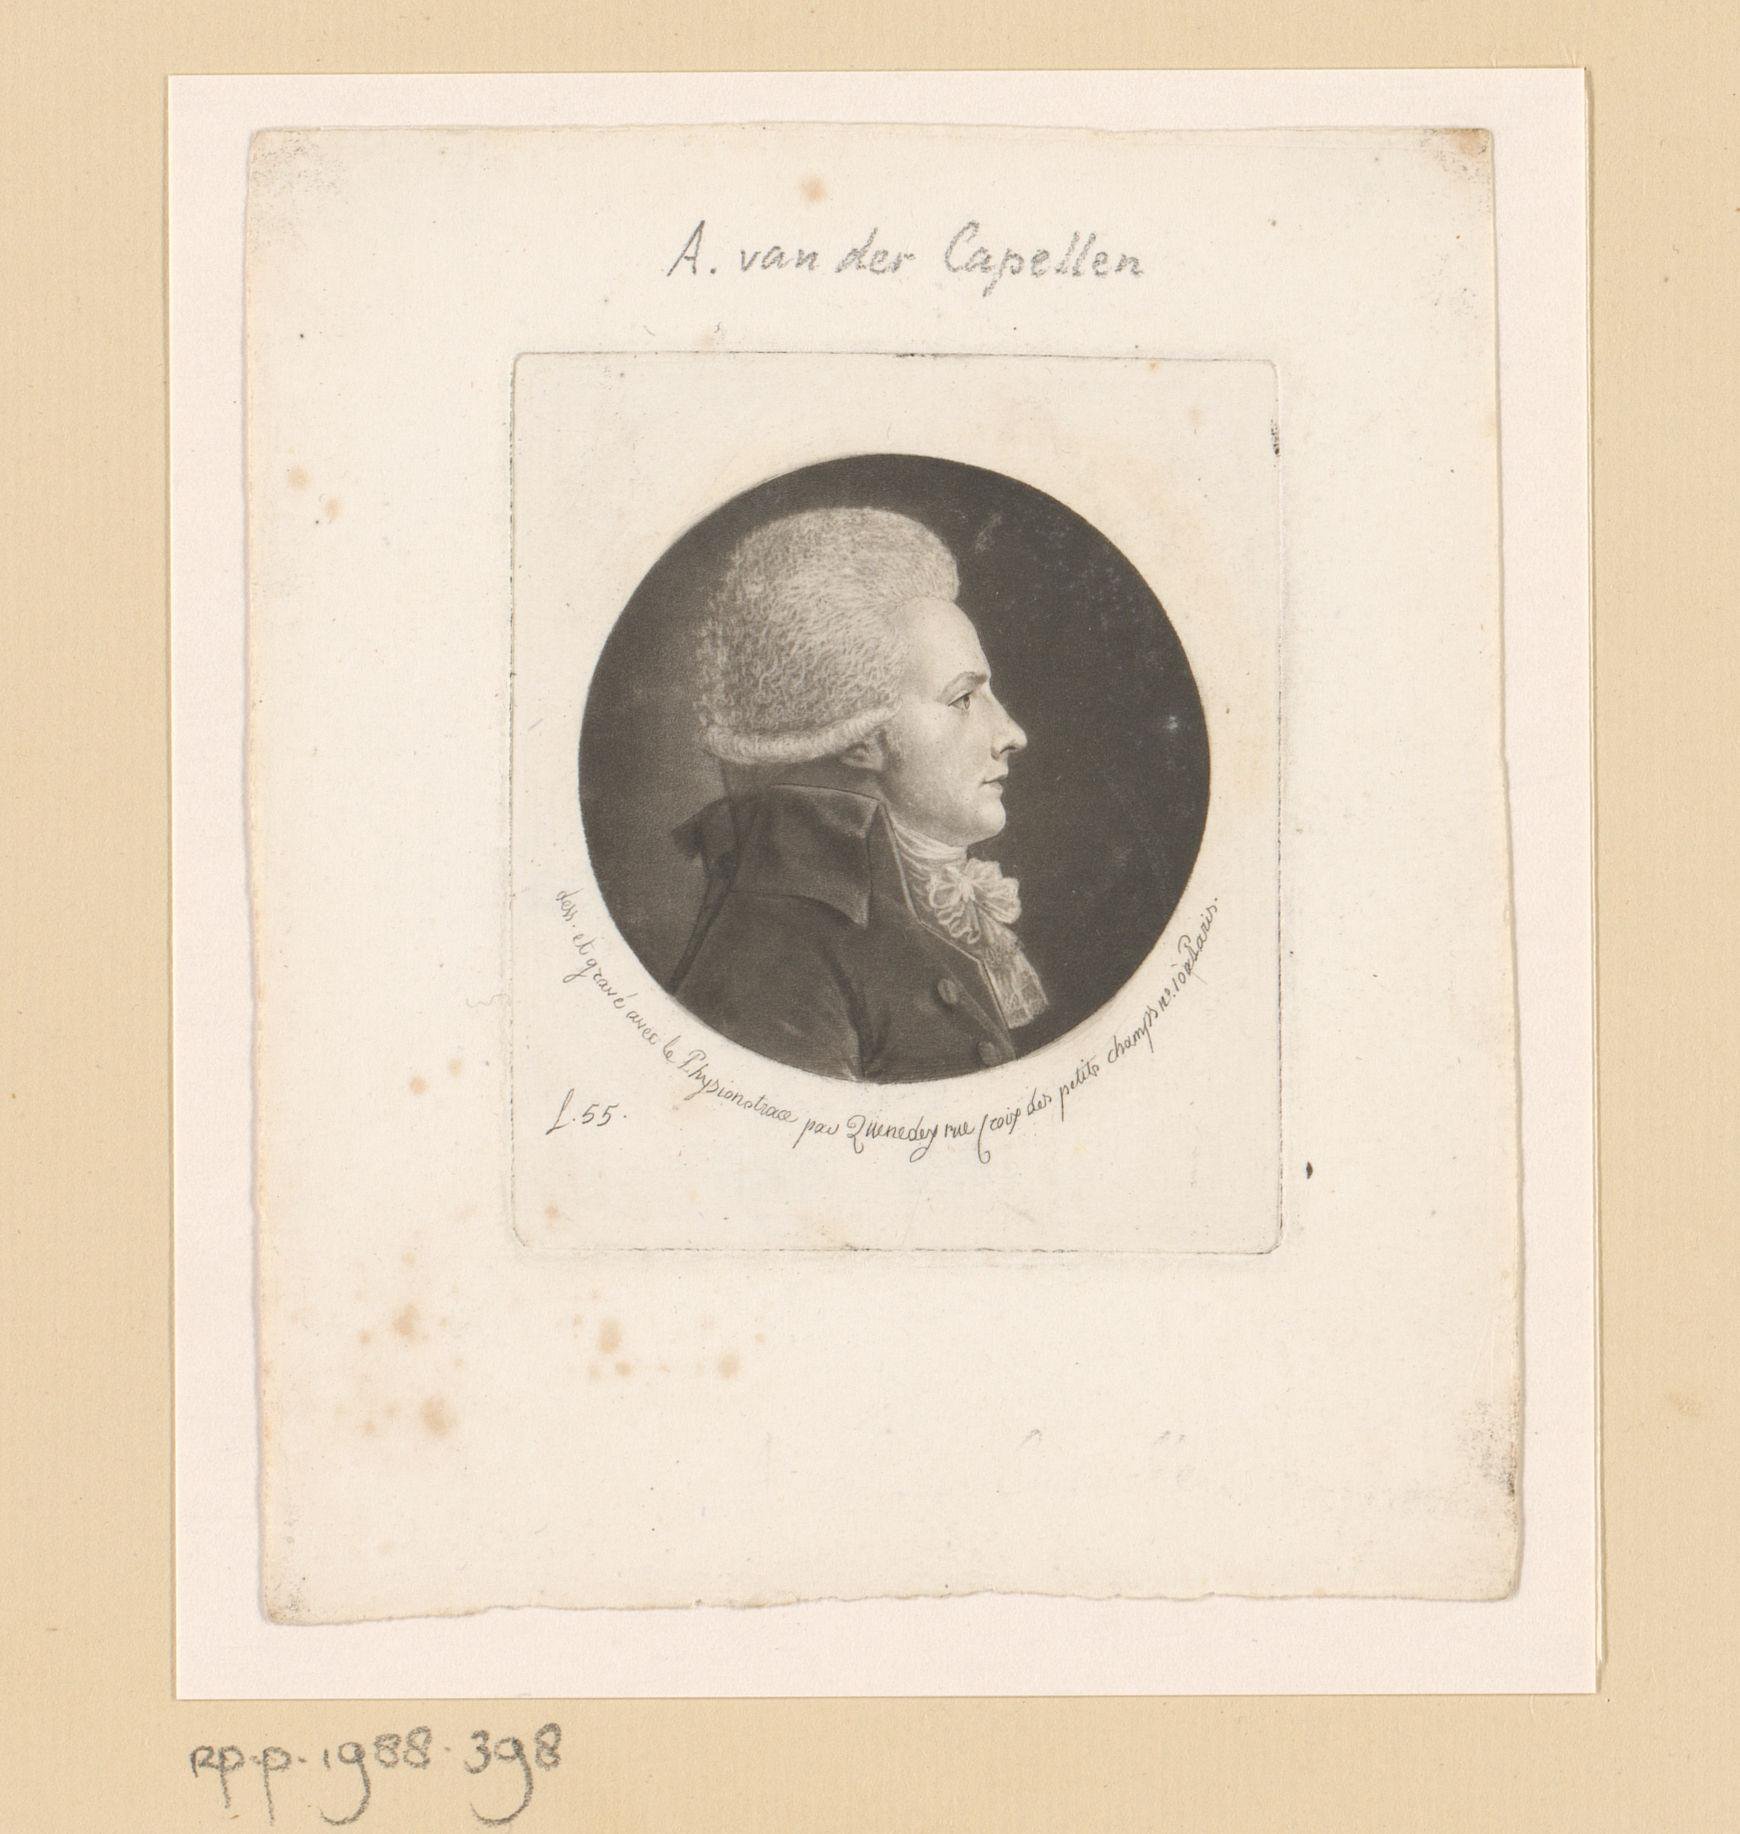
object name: print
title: Portret van Alexander Philip van der Capellen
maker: edme quenedey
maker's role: print maker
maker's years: 1756-1830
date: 1785-1787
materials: paper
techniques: aquatint, etching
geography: paris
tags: warnsveld, silhouette-apparatus, 'physionotrace', historical persons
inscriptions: collector's mark: Lugt 2228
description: Deze prent heeft het nummer L.55 in het fonds van Quenedey.